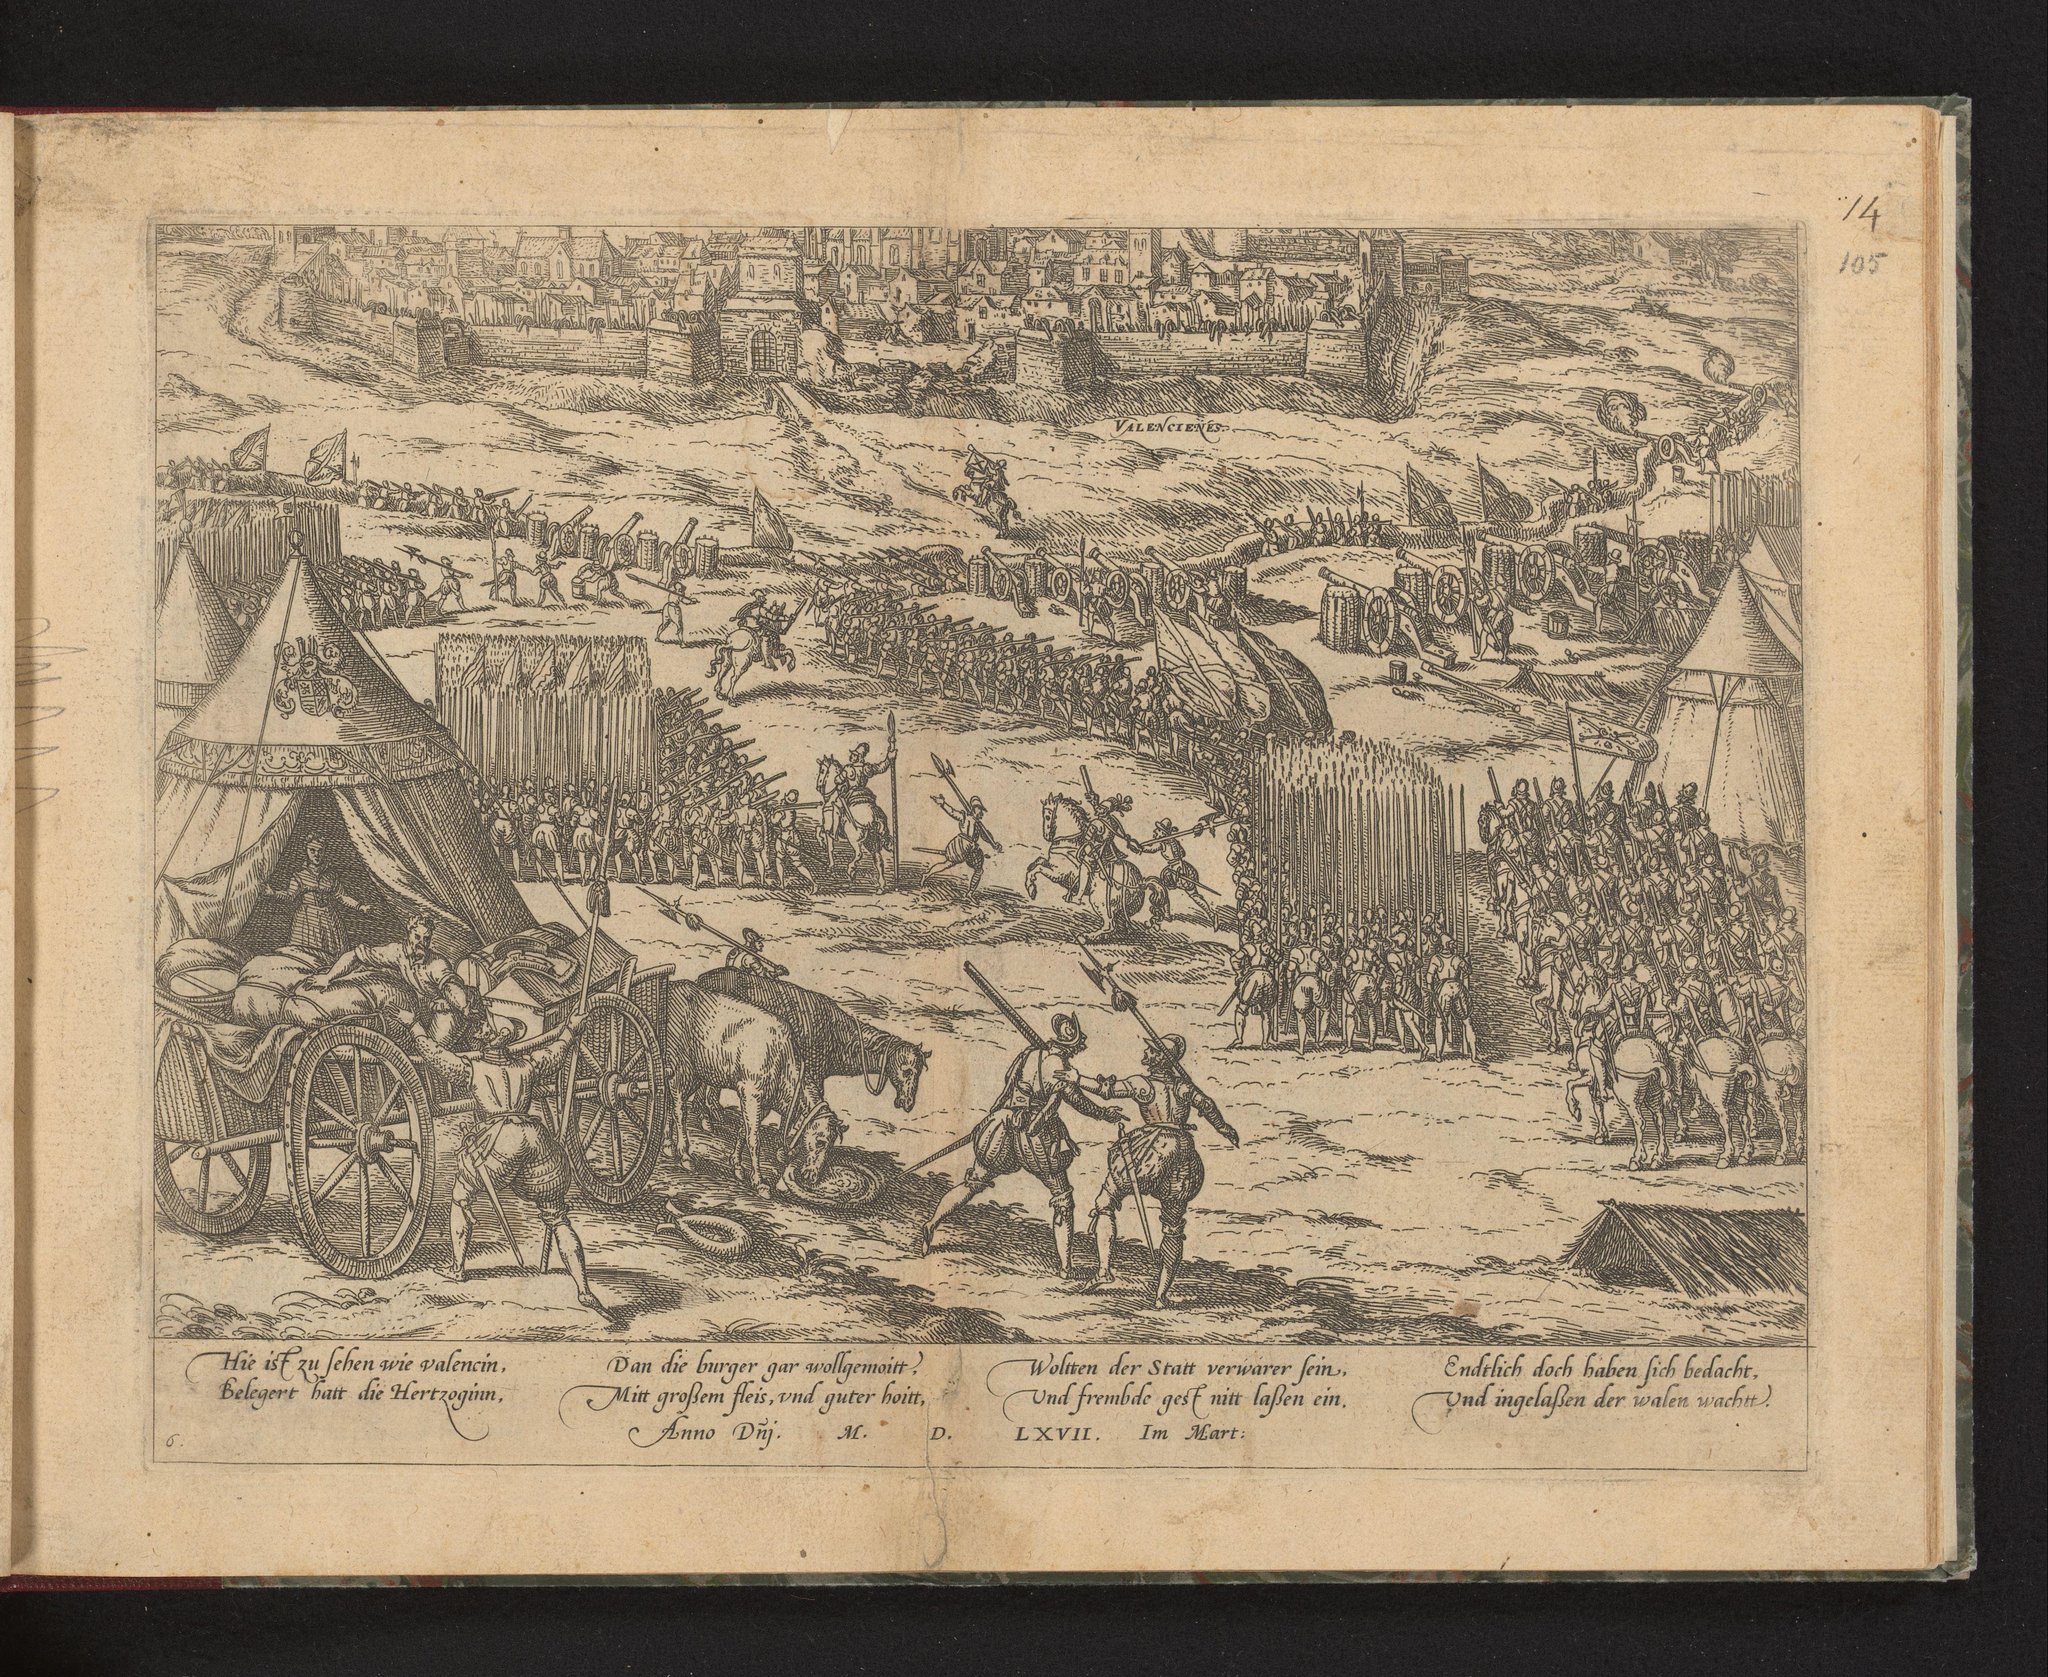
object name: album leaf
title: Serie 5: Nederlandse Gebeurtenissen, 1566-1570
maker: frans hogenberg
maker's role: print maker, publisher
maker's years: 1538-1590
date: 1567-1570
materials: paper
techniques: etching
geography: cologne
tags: utrecht, capture of city (after the siege)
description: Inname van Valenciennes. De stad wordt door de heer van Noircarmes heroverd op de calvinisten, maart 1567. Gezicht vanuit het legerkamp van Noircarmes op de stad. Met onderschrift van 8 regels in het Duits. Genummerd: 6. De prent maakt deel uit van een album.